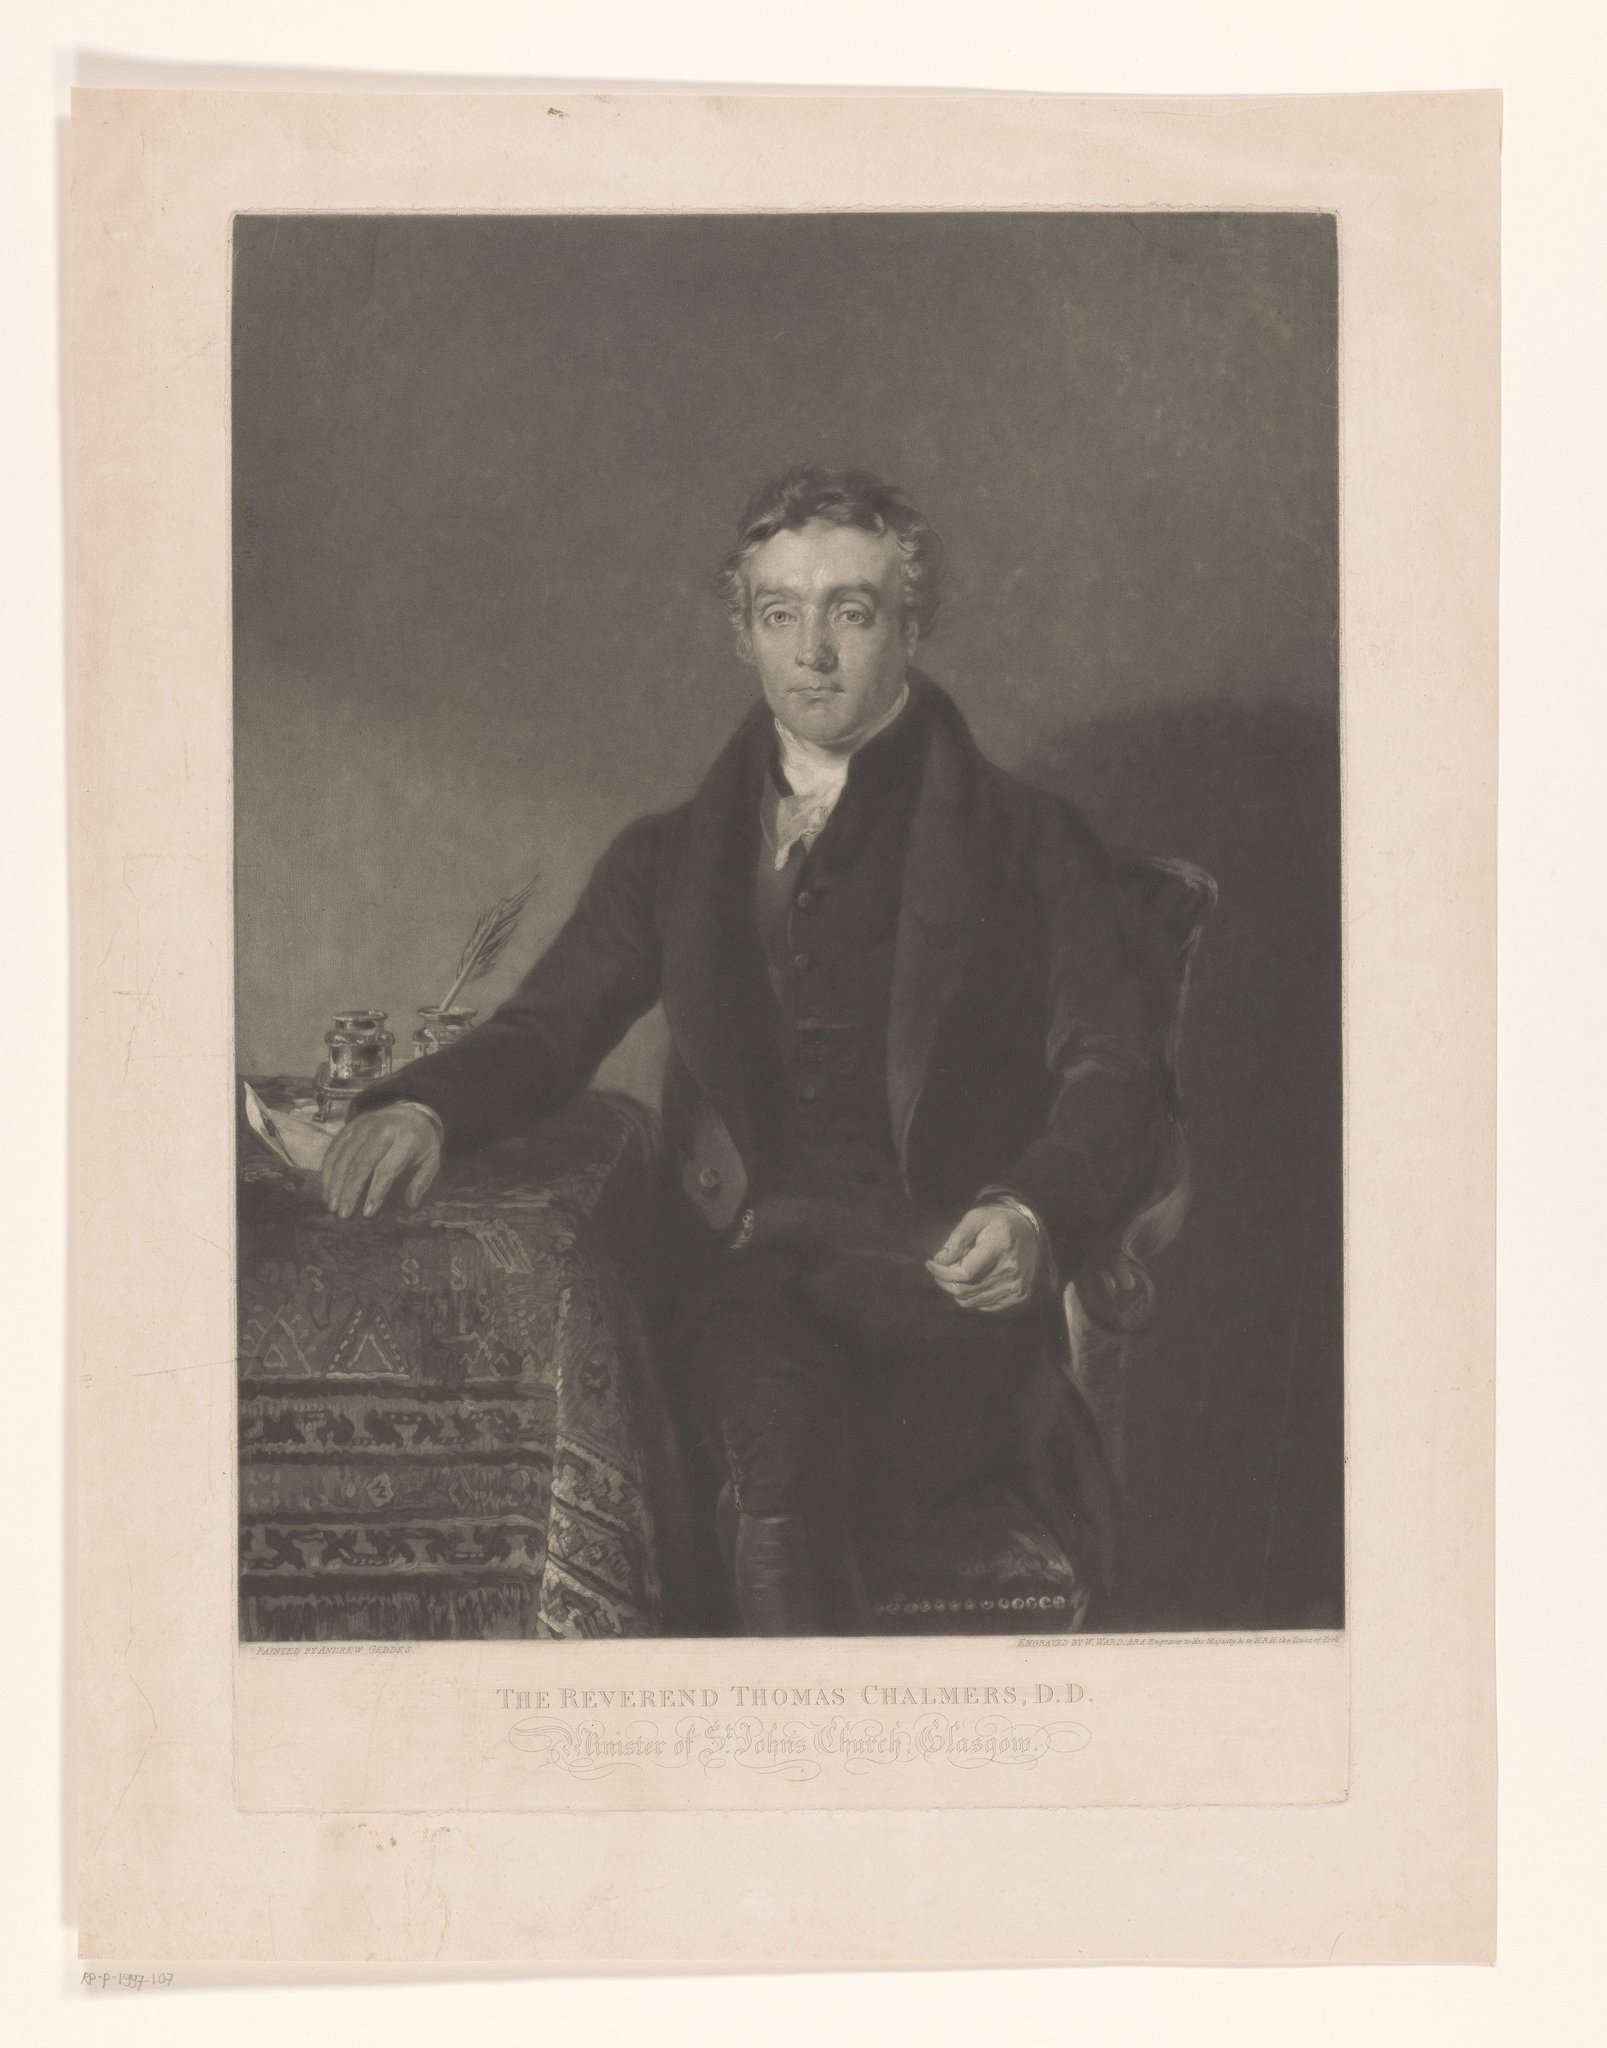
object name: print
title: Portret van Thomas Chalmers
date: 1767-1826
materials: paper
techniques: mezzotint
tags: historical persons, functionaries and dignitaries ~ protestant churches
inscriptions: collector's mark: Lugt 2228